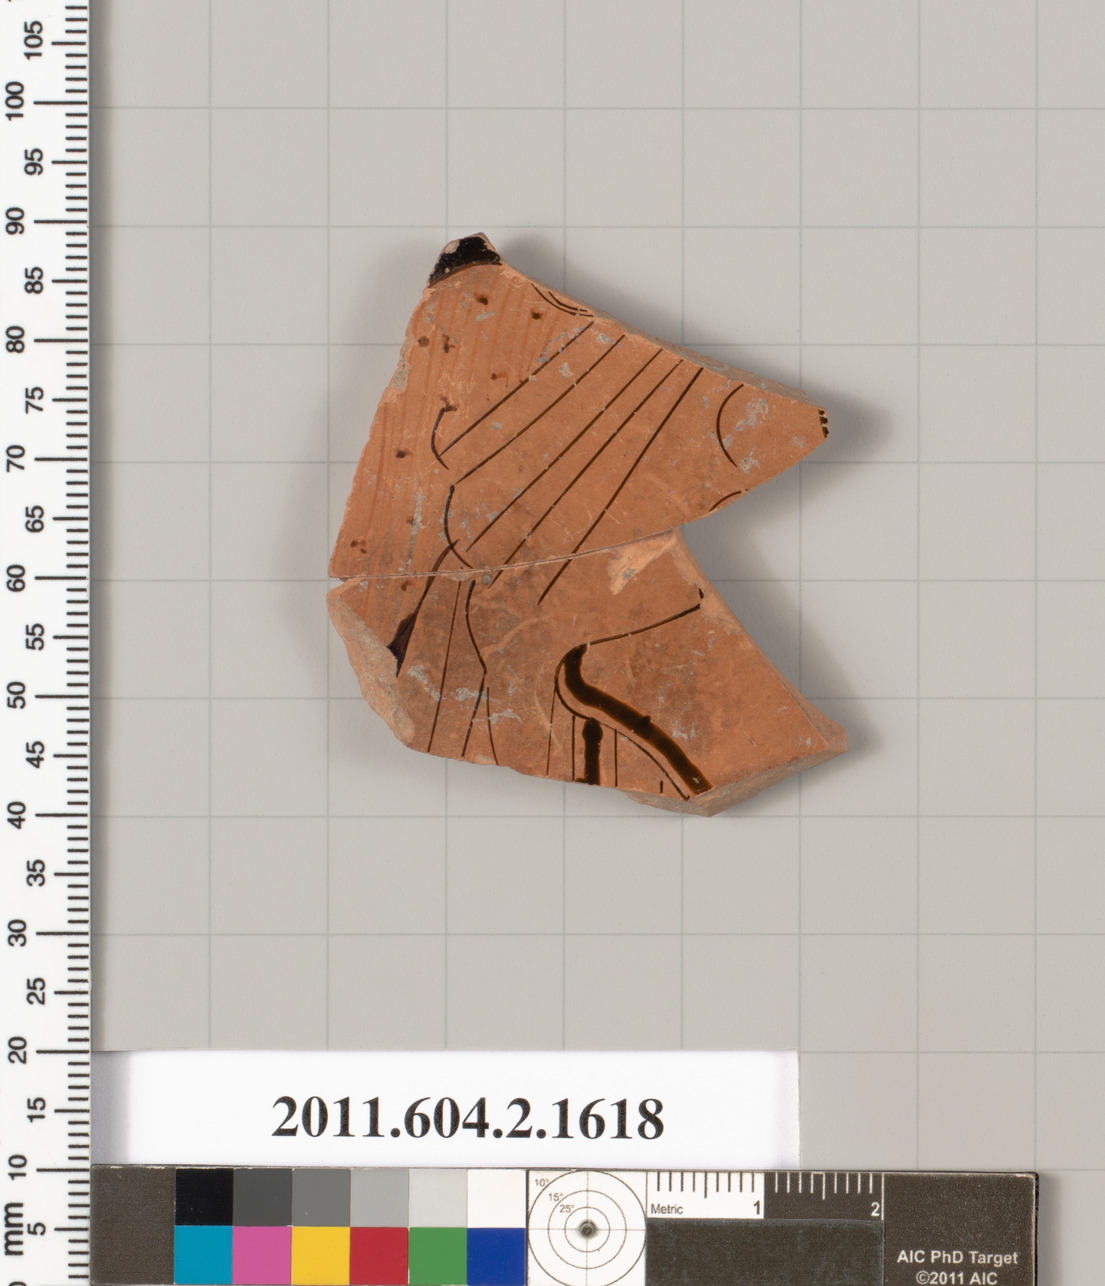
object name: skyphos fragment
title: Terracotta fragment of a skyphos (deep drinking cup)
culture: greek, attic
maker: penthesilea painter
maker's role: artist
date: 460-450 BCE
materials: terracotta